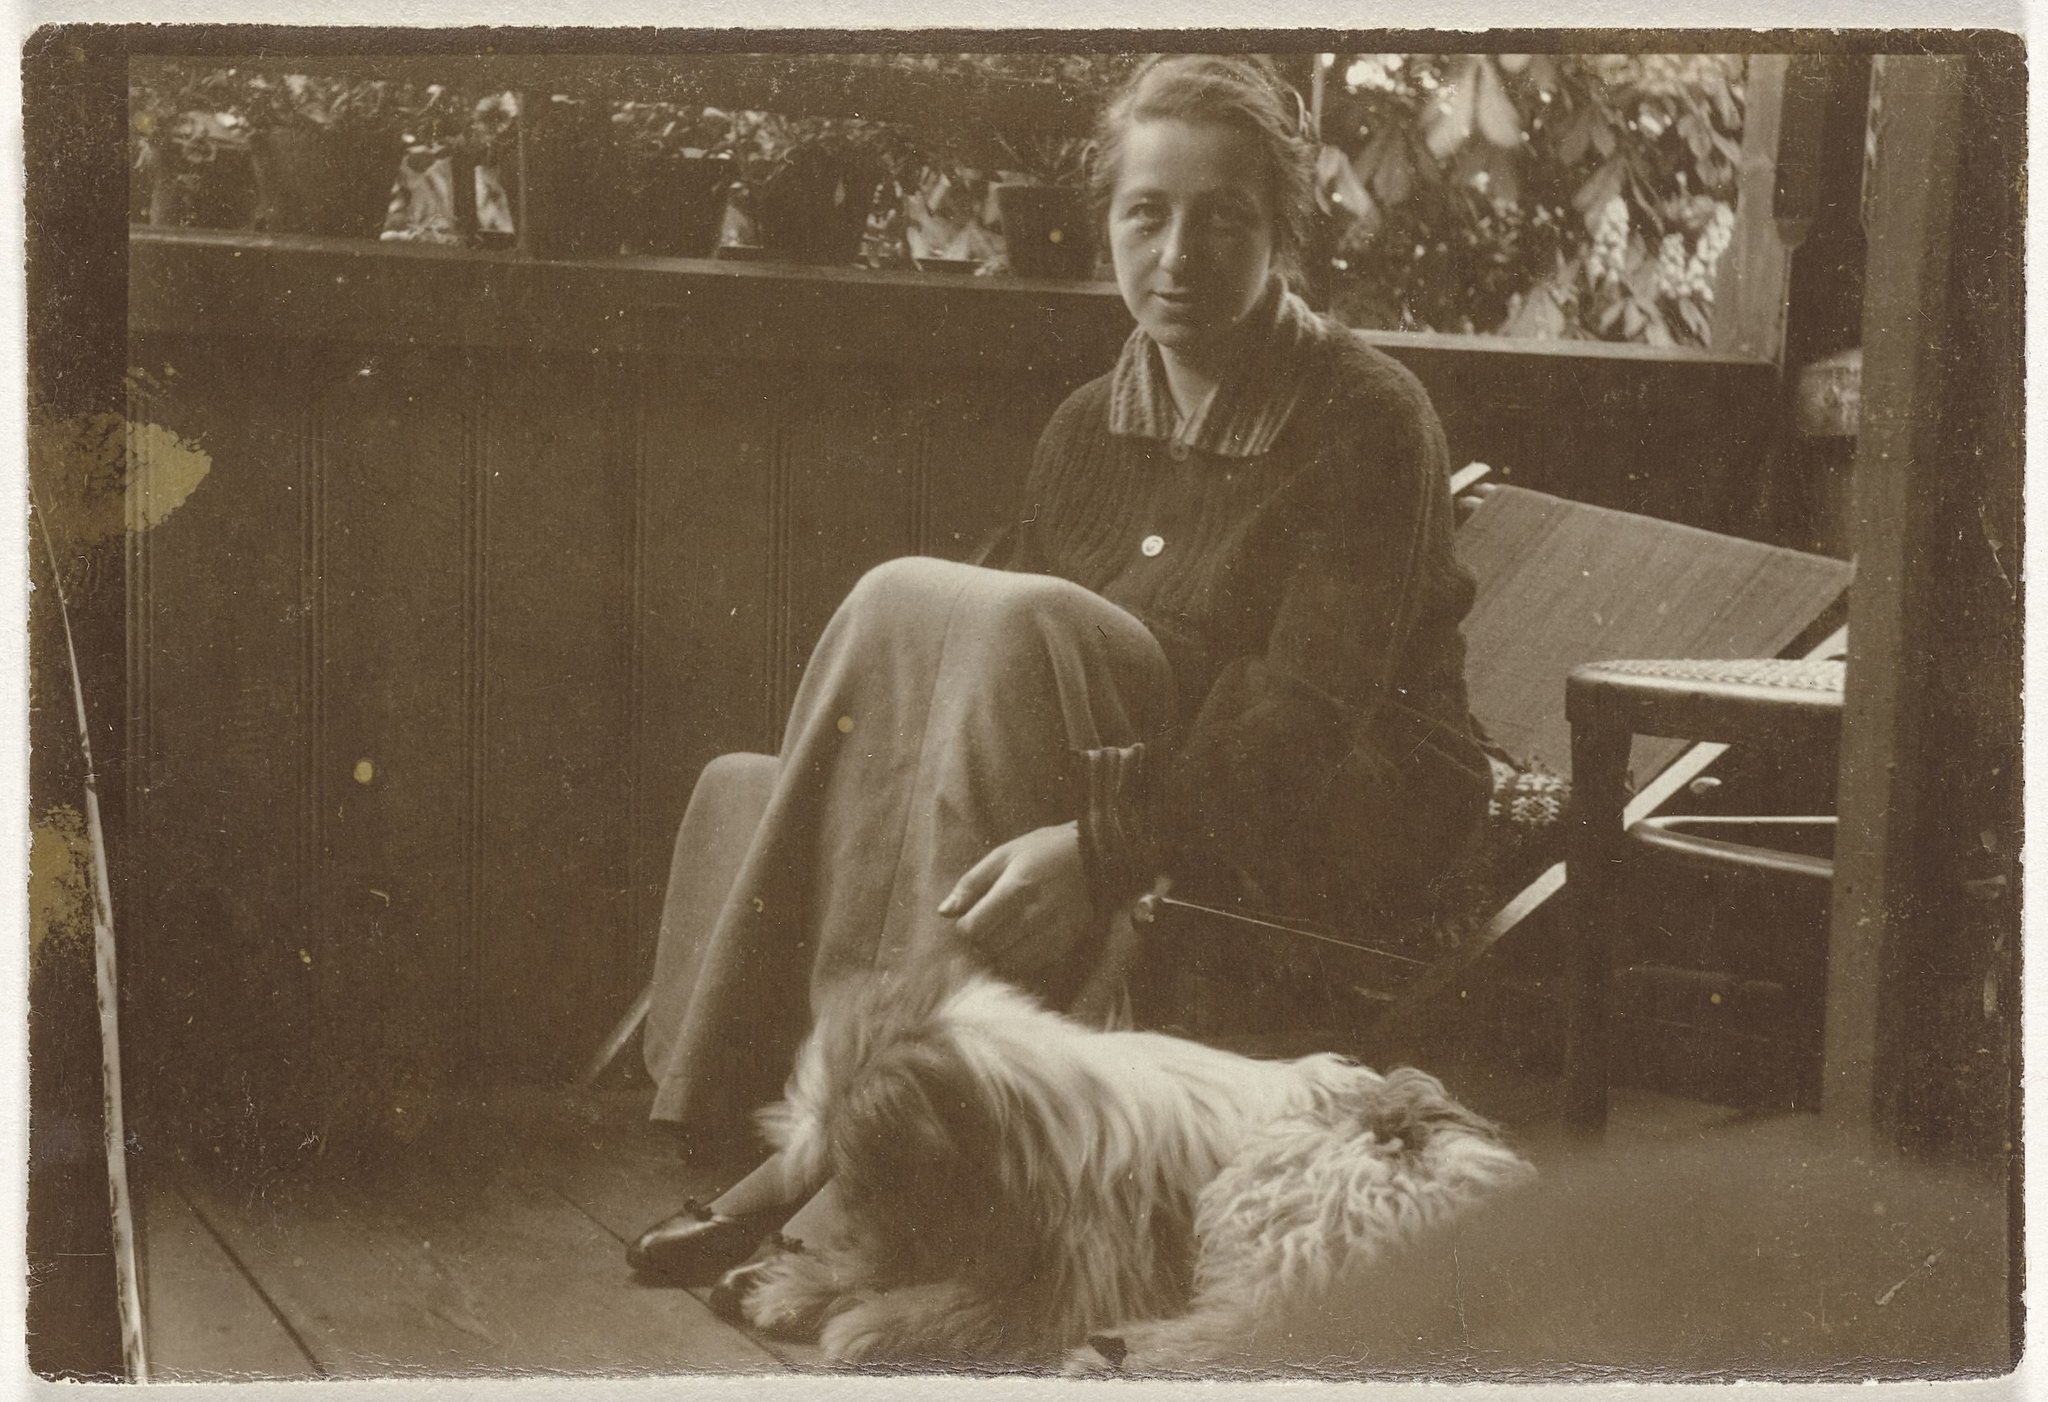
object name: photograph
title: Portret van Irene With met hond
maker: Anonymous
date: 1920-1930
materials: paper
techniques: gelatin silver print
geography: germany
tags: adult woman, historical persons, dog, germany